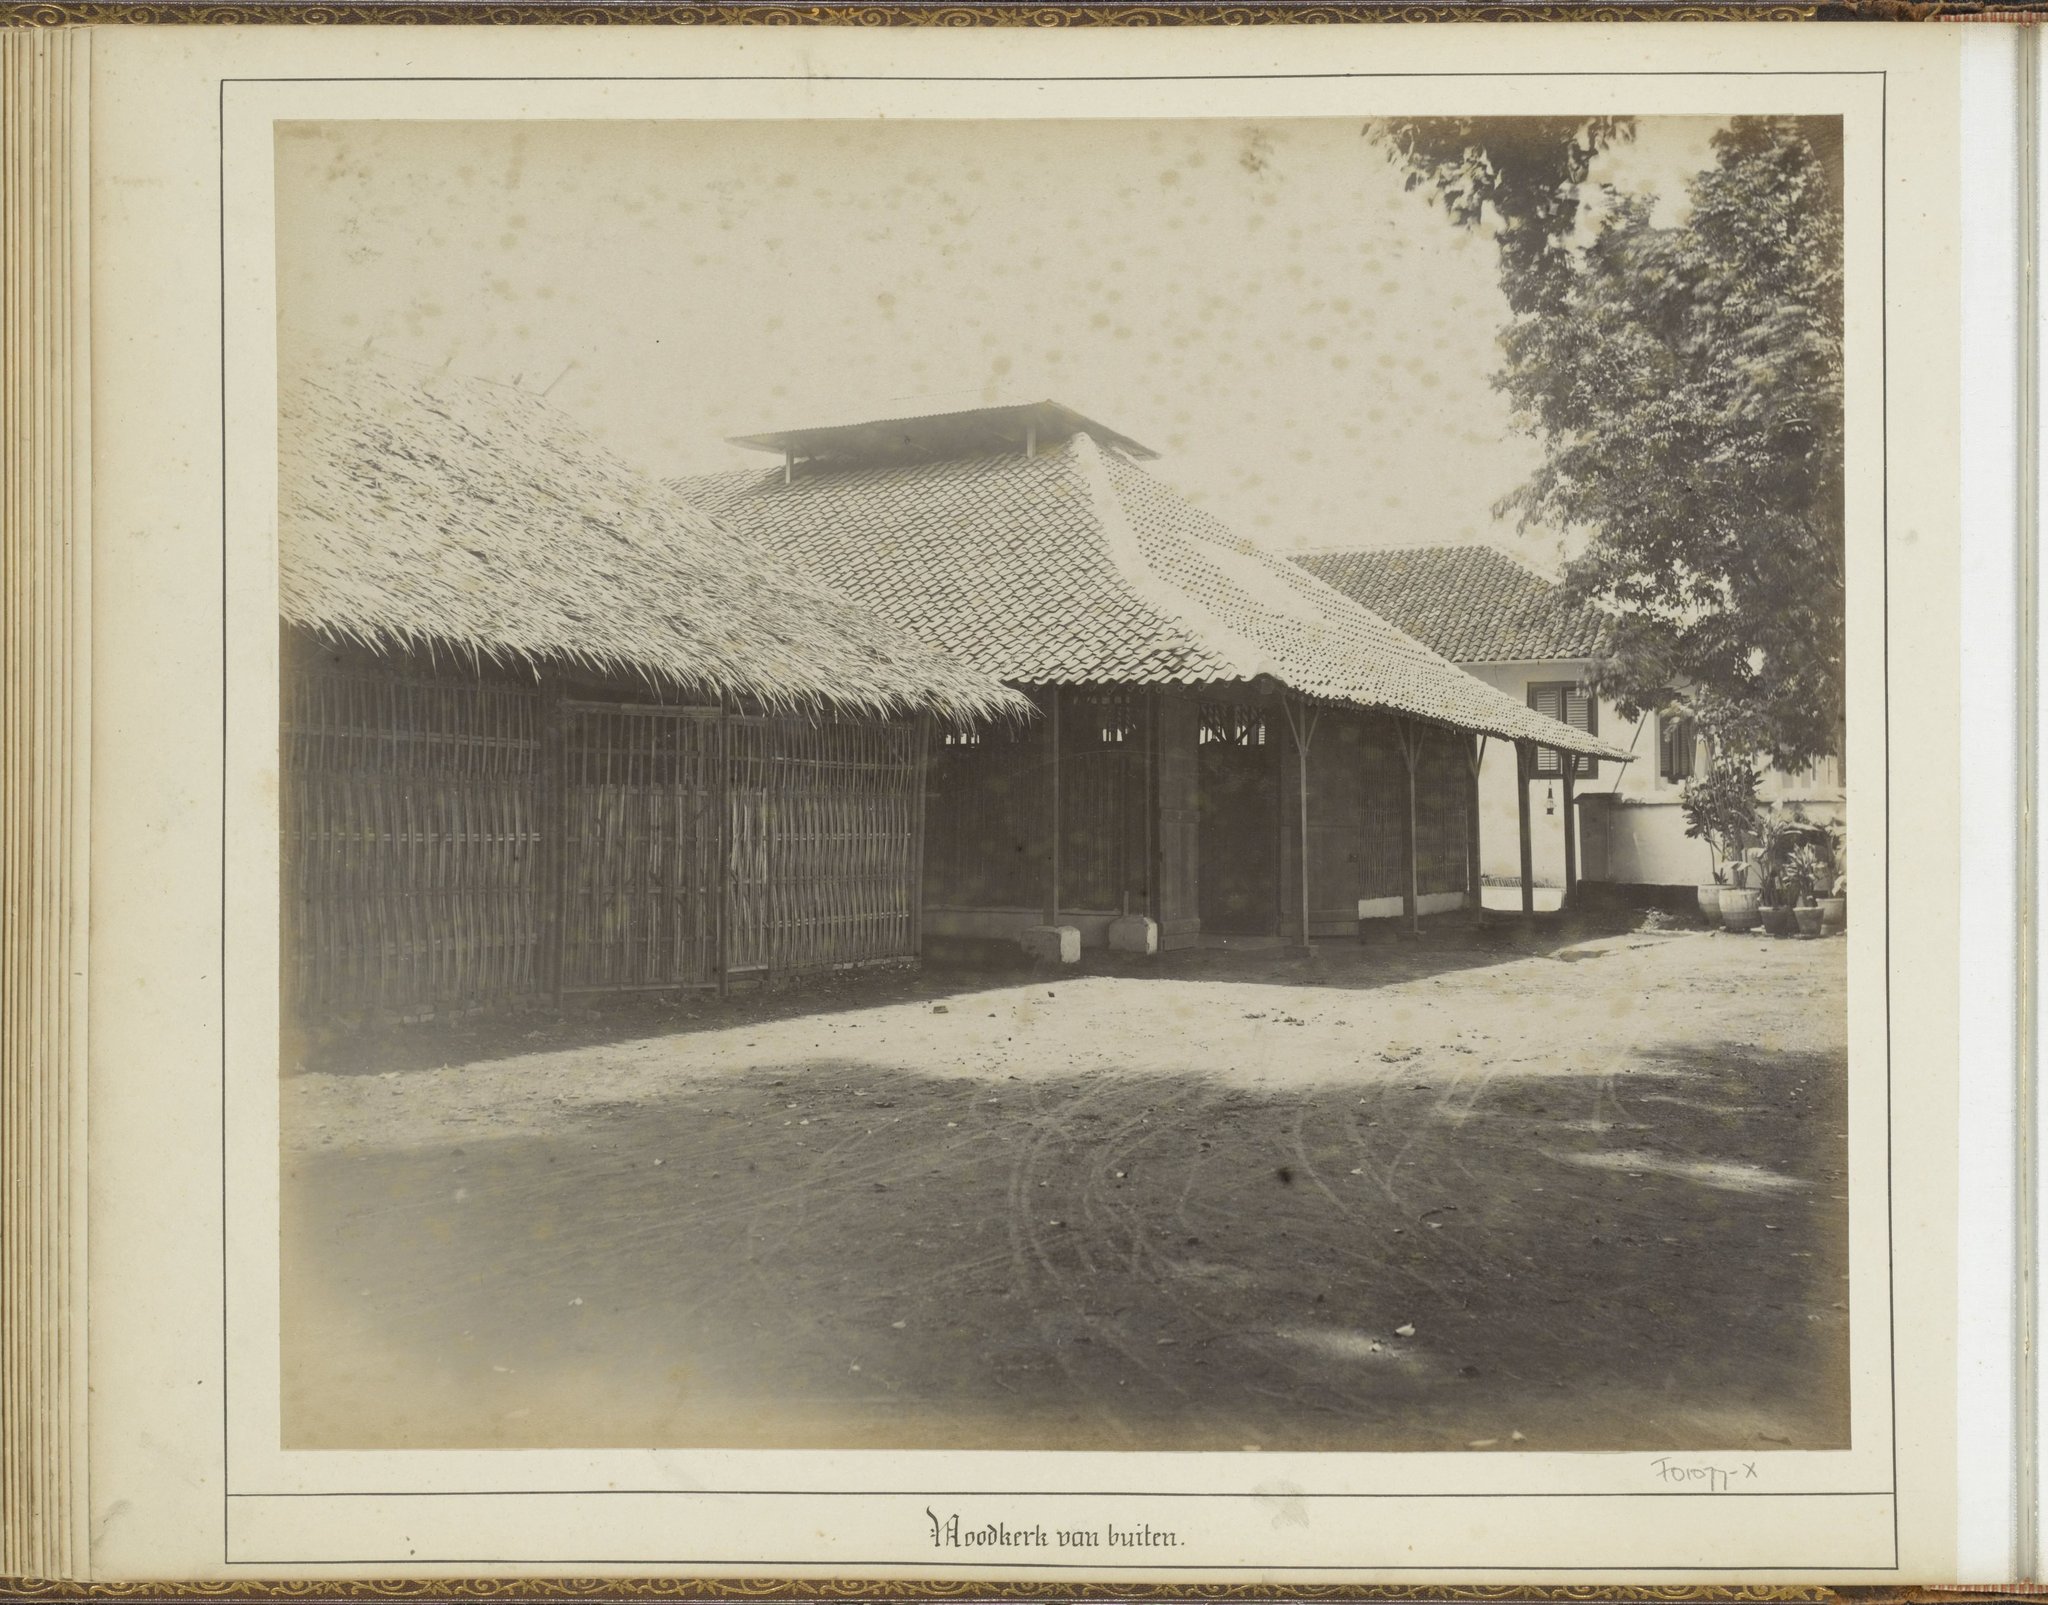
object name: album leaf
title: Exterieur van de noodkerk in Batavia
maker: Anonymous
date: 1890-1910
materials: cardboard, photographic support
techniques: albumen print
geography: batavia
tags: church (exterior), batavia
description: De noodkerk werd gebouwd na het instorten van een deel van de rooms-katholieke kerk in Batavia in 1890. Onderdeel van Album met foto's van Batavia.